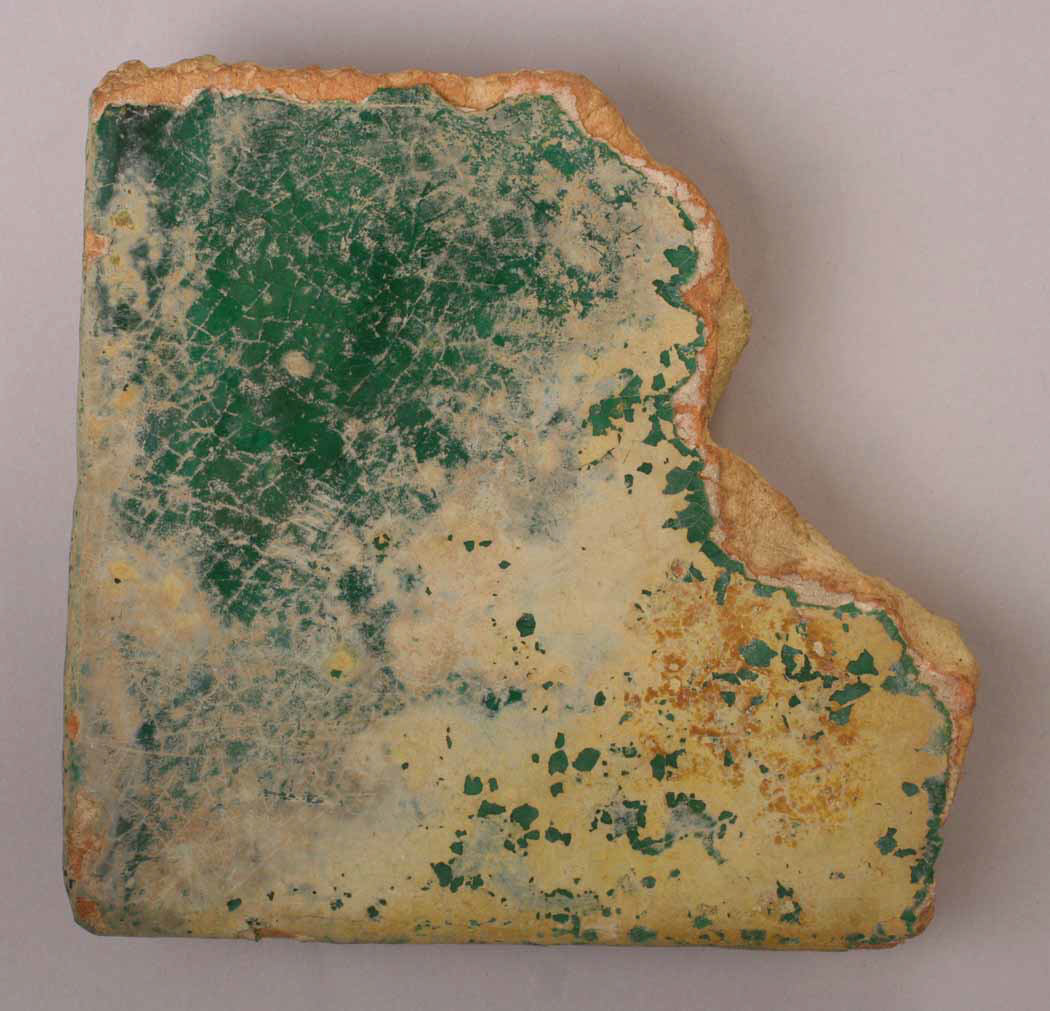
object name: tile fragment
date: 801-900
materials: earthenware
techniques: glazing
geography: iraq